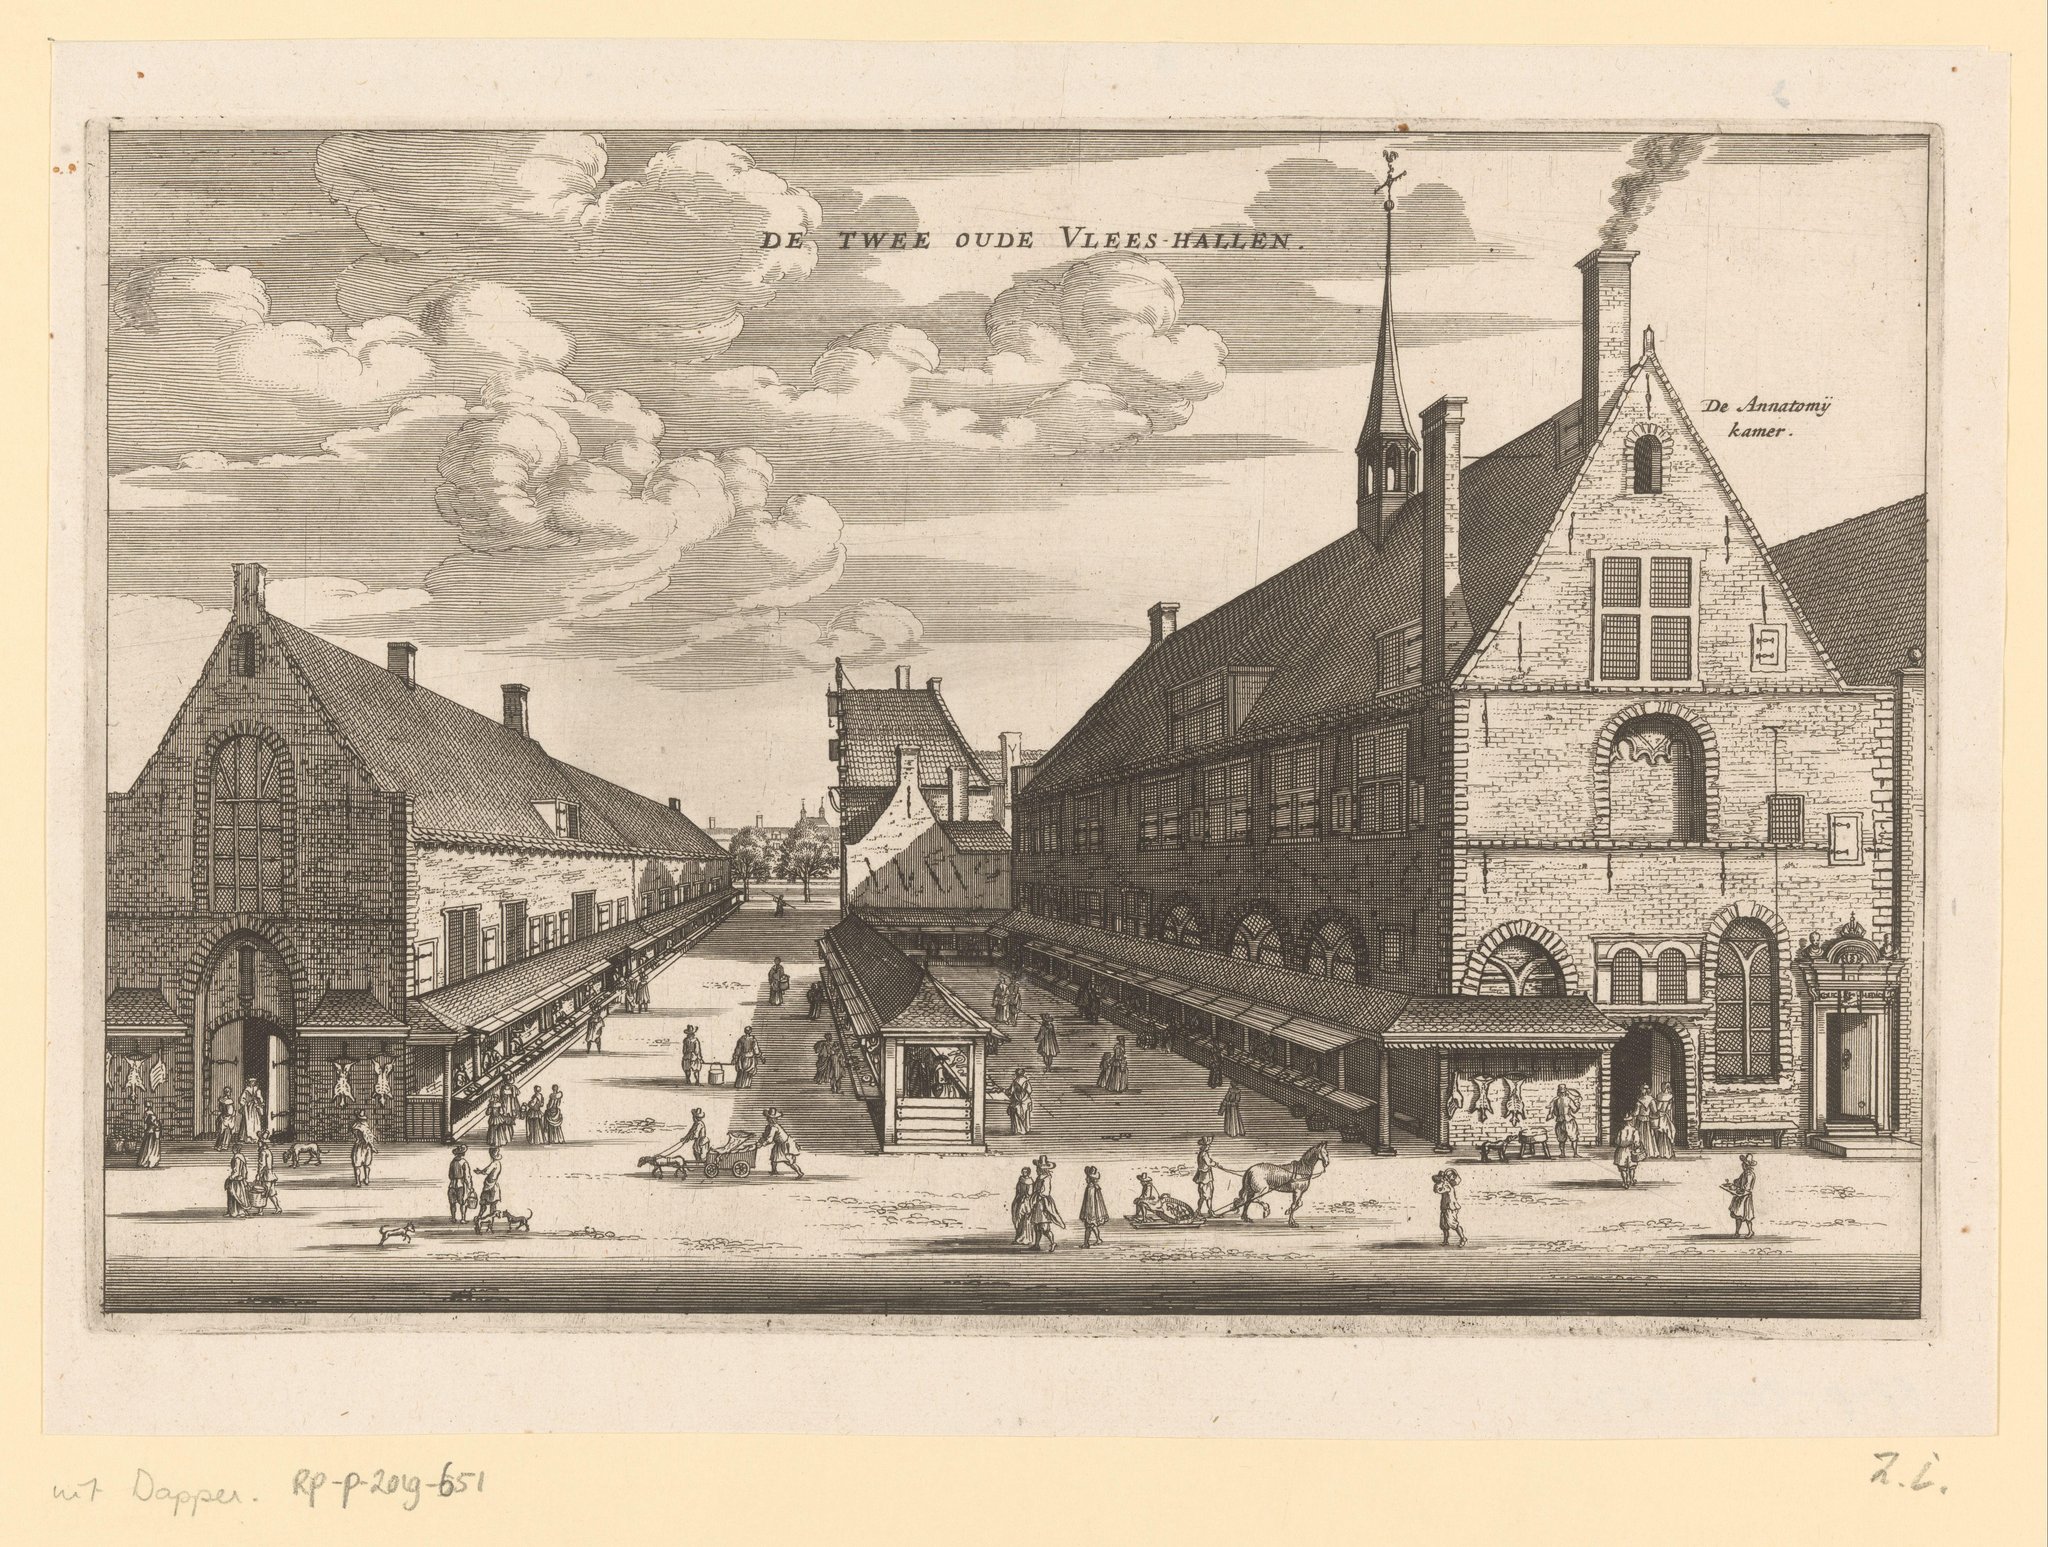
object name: print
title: De twee oude Vlees-hallen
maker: jacob van meurs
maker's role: draughtsman, print maker, publisher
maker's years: 1619-1680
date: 1663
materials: paper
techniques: engraving, etching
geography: amsterdam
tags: market, market-hall, street (+ city(-scape) with figures, staffage)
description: Prent uit: Dapper, Olfert. Historische beschryving der stadt Amsterdam: waer in de voornaemste geschiedenissen (na een kort verhael van gansch Hollant en d'omleggende dorpen (…). Amsterdam: Jacob van Meurs, 1663. Latere staat van prent heeft een toegevoegde Franse titel.